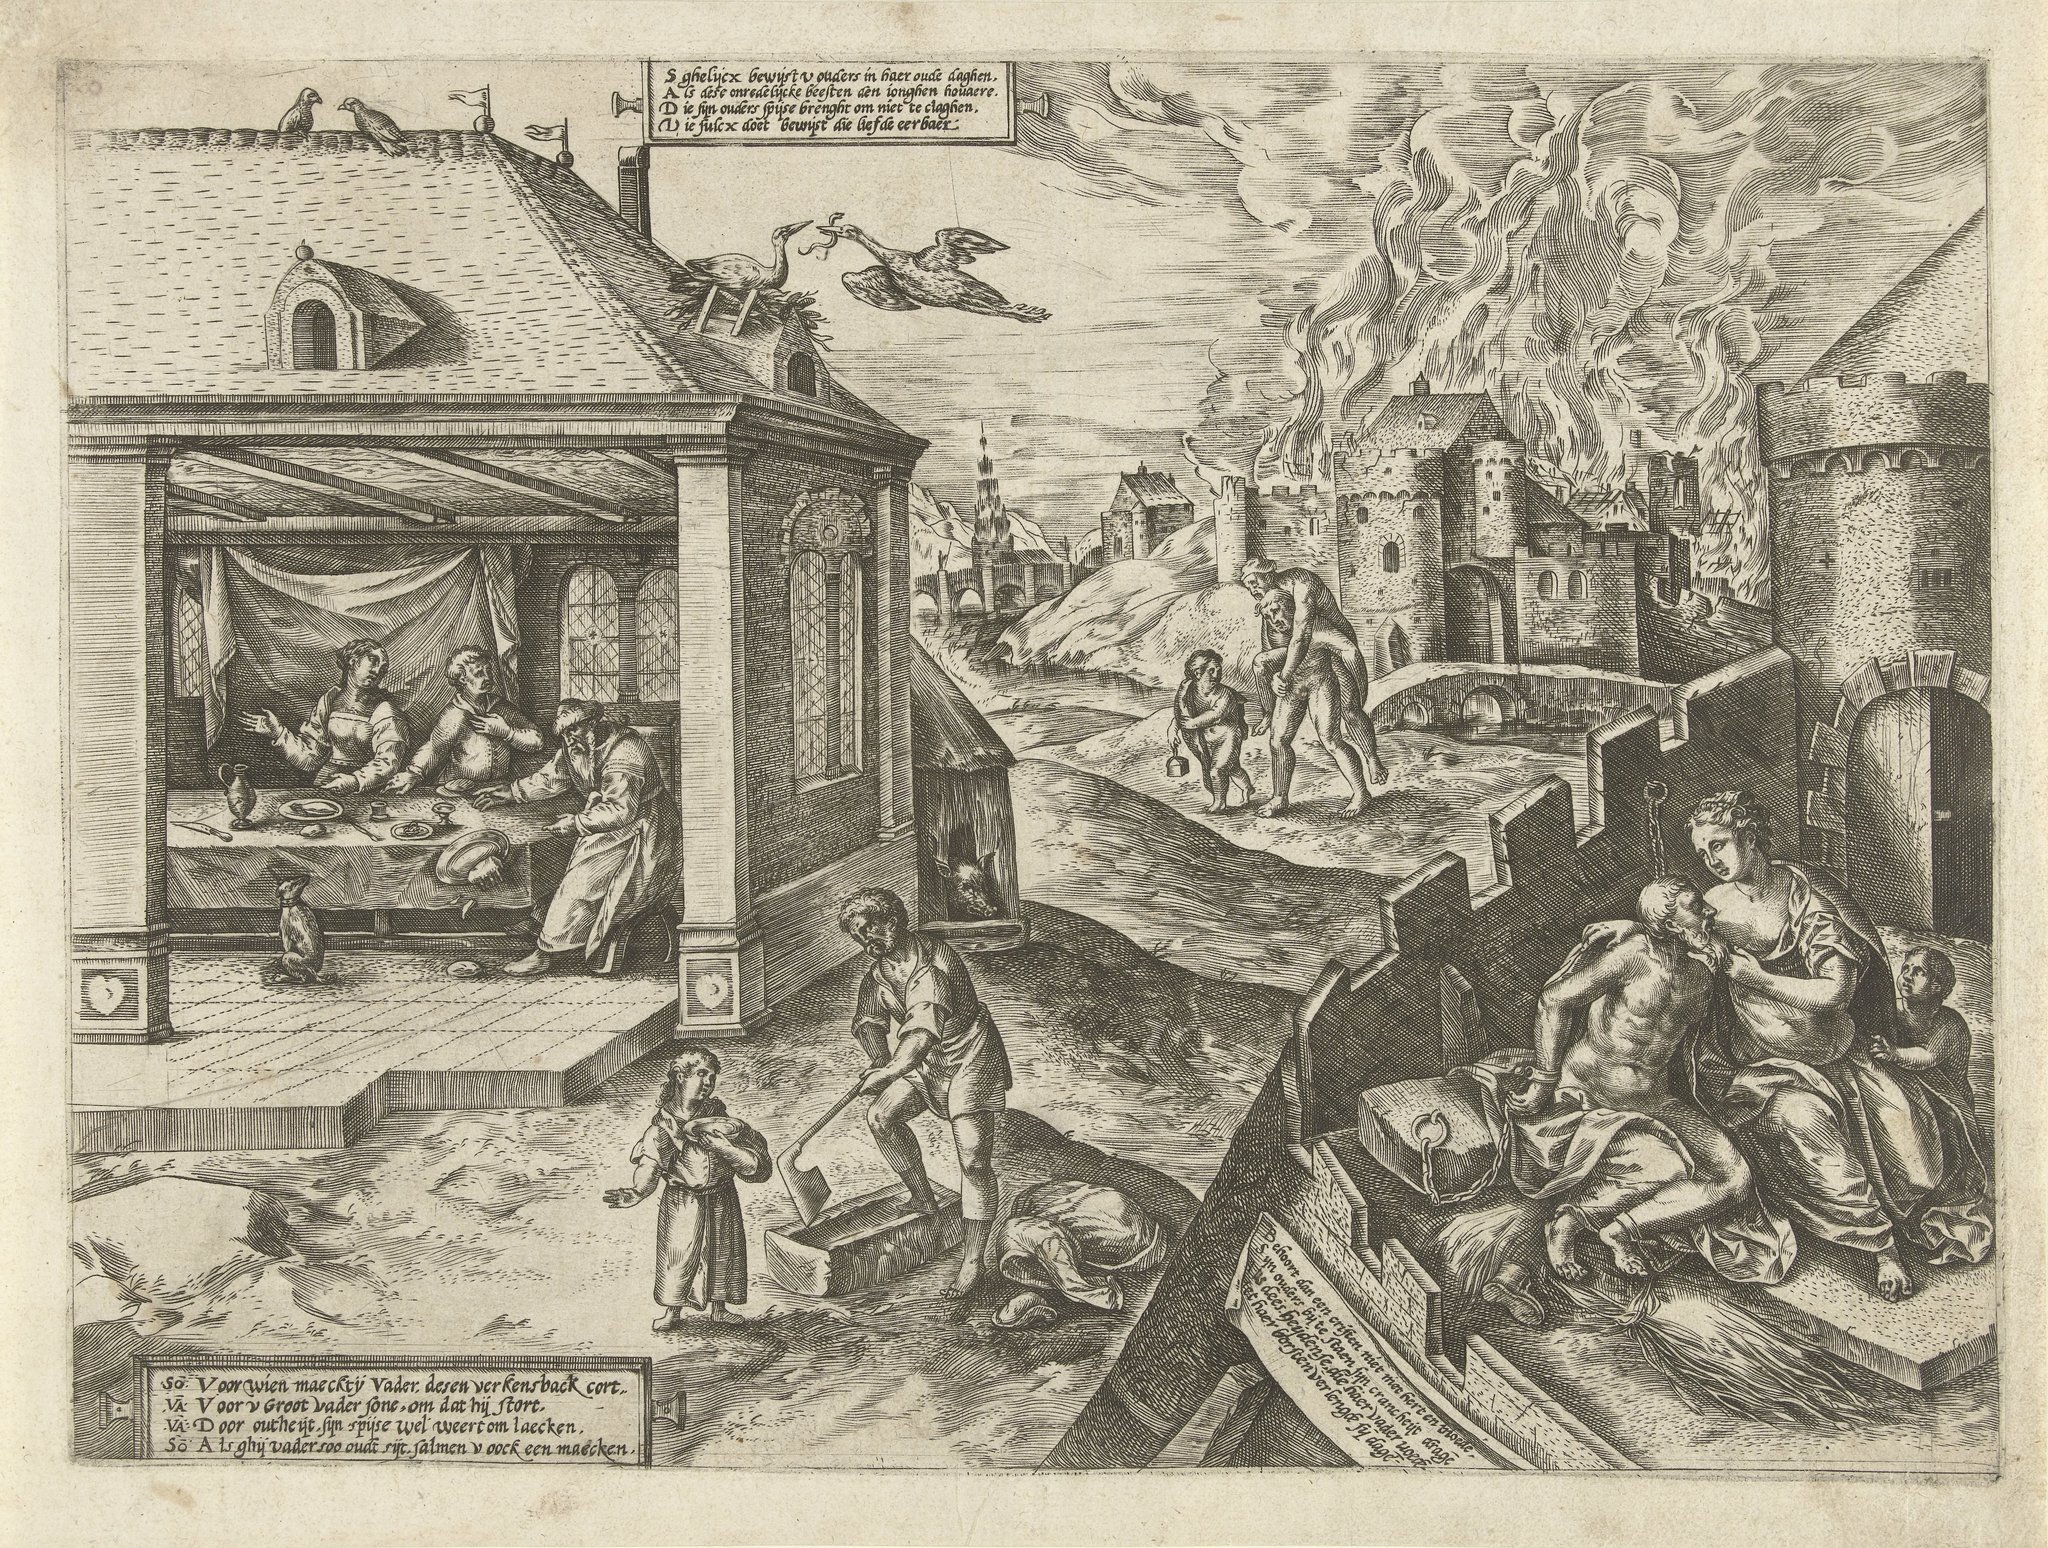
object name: print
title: Allegorieën op de liefde van kinderen voor hun ouders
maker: peeter baltens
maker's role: draughtsman, painter, print maker, publisher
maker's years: 1527-1584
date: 1540-1584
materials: paper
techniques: engraving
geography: antwerp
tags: 'pius aeneas': aeneas, leading ascanius, escapes from burning troy, carrying his father anchises with the penates; his wife creusa, who sets out with them, is lost on the way, pero suckling cimon ('caritas romana'), absence of filial love, filial love, 'pietas filiorum'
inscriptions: collector's mark: Lugt 2228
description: Verschillende scènes die de liefde van kinderen voor hun ouders, of de afwezigheid ervan verbeelden zijn in een voorstelling gecombineerd. Rechtsonder het verhaal van Cimon en Pero, in het midden een man die voor zijn vader een voederbak maakt, en door zijn zoontje terecht gewezen wordt, links een jong stel dat een oude man van tafel stuurt, op het dak een vogel die zijn jongen voedt, op de achtergrond Aeneas die zijn vader redt uit het brandende Troje. Met uitleg in het Nederlands.